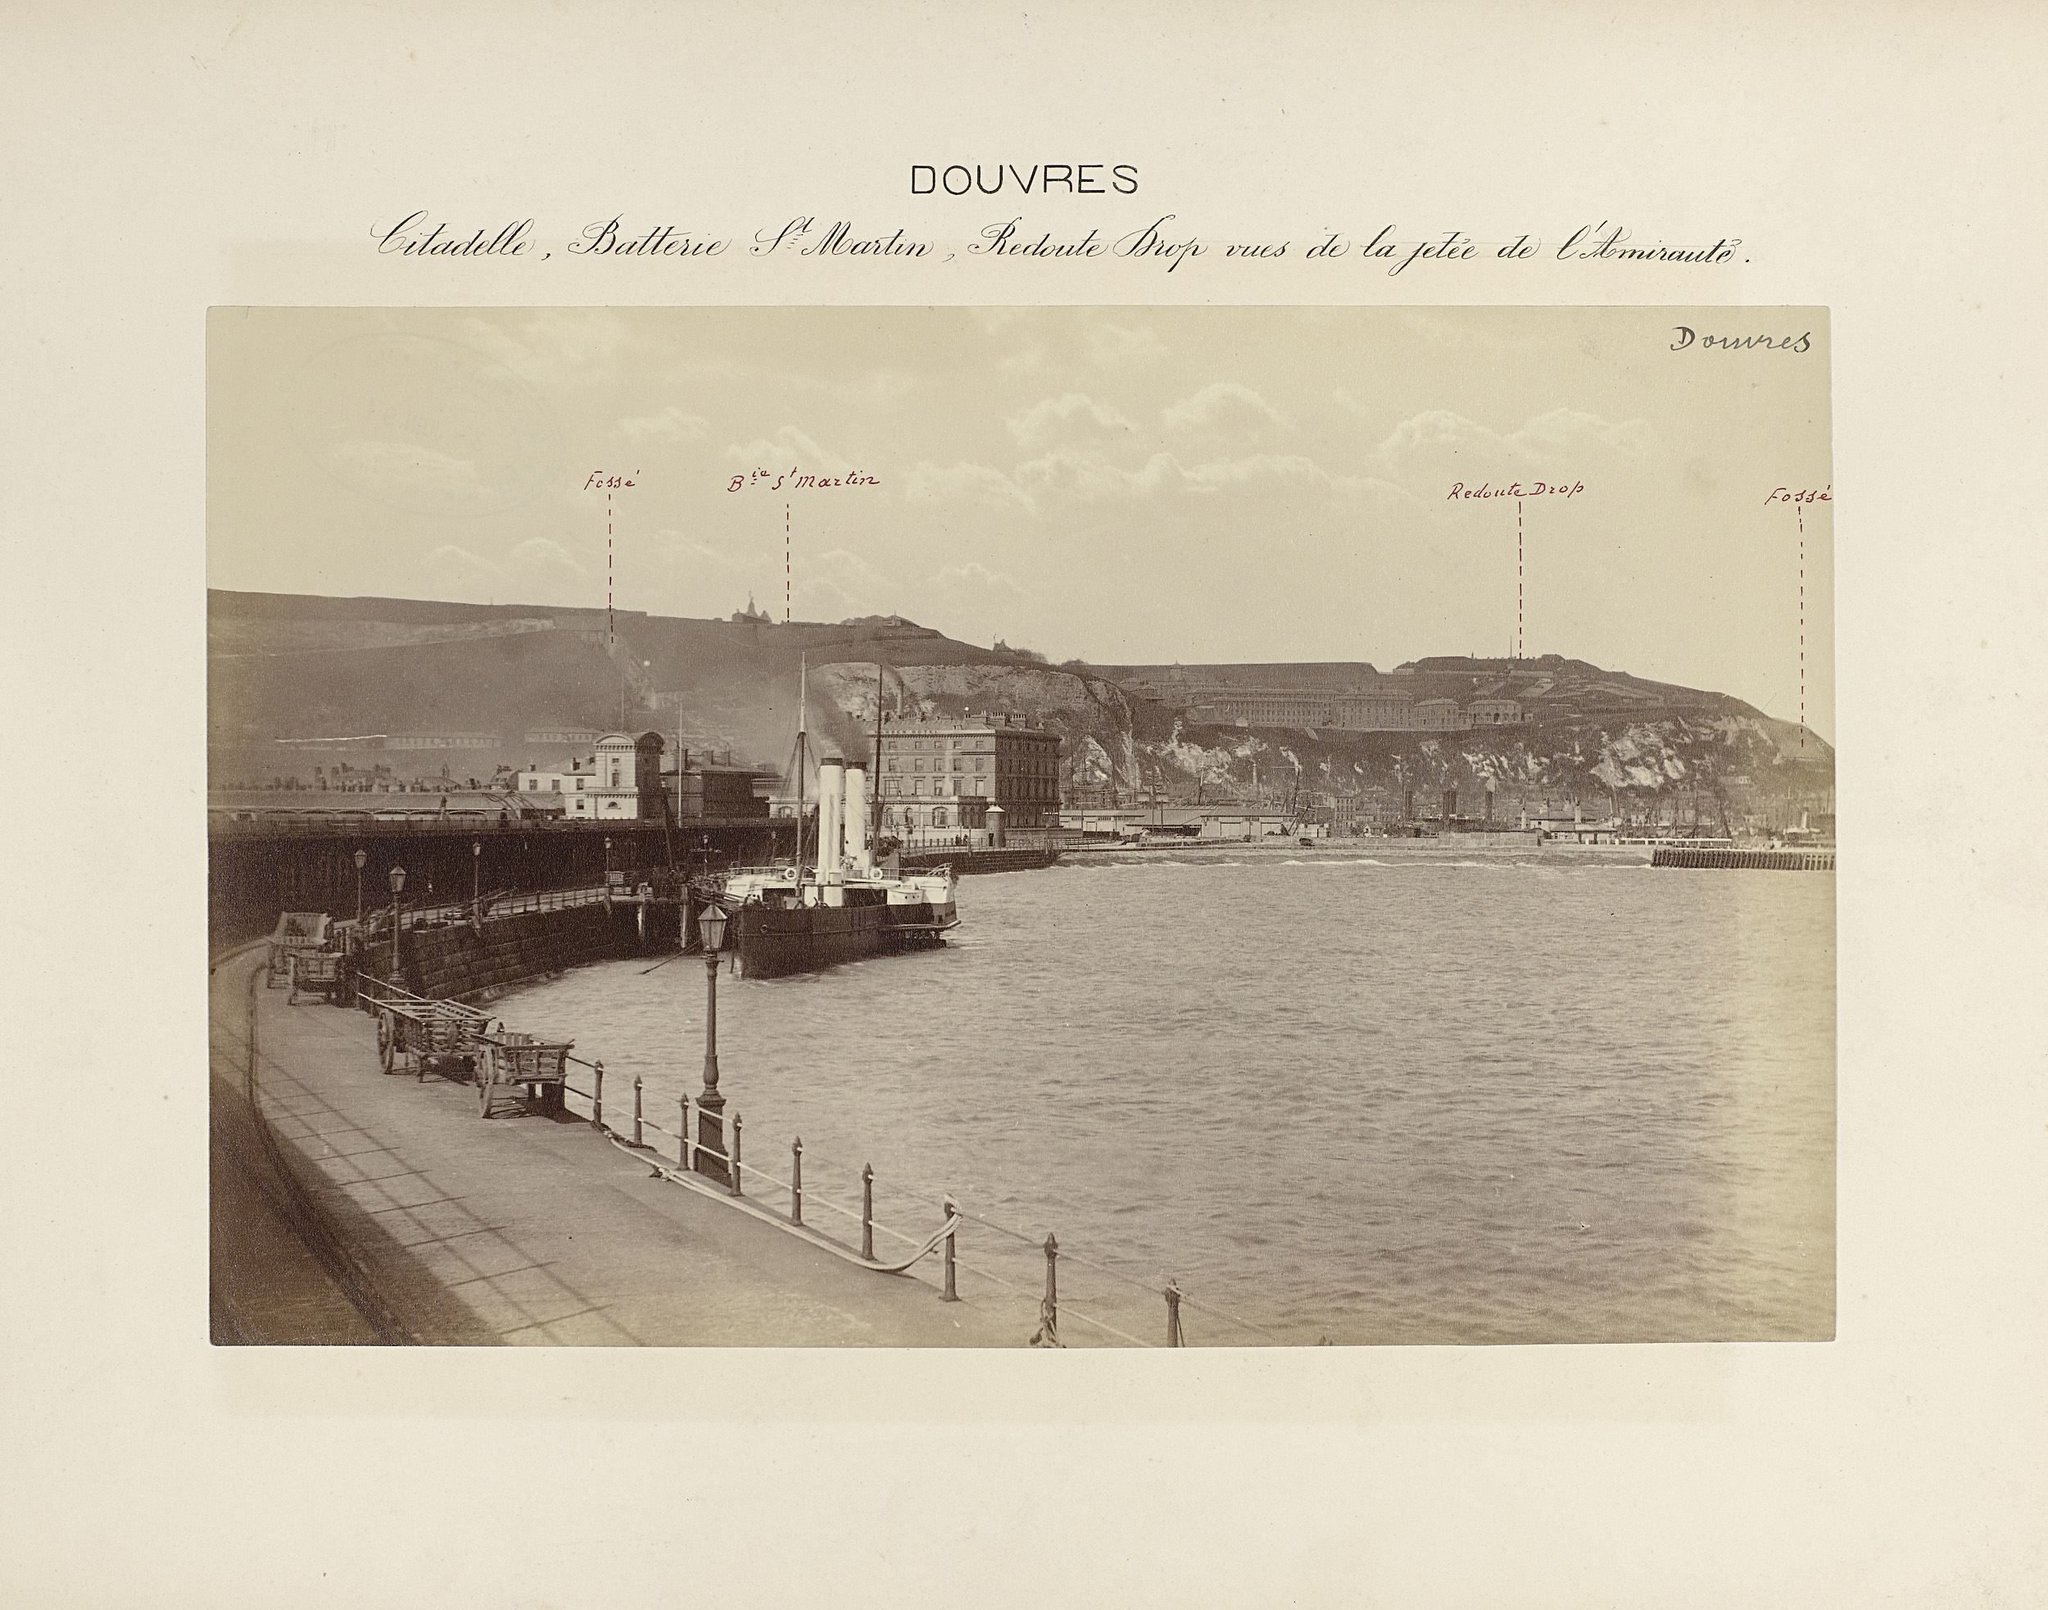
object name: photograph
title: Angleterre. Défense des côtes. Reconaissance de 1891. Photographies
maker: Anonymous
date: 1891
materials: cardboard, paper, photographic support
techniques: albumen print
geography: great britain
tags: dover (engeland)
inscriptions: annotation: ‘Fossé // B[atter]ie St Martin // Redoute Drop // Fossé’, inscription: ‘Douvres’, inscription: ‘DOUVRES / Citadelle, Batterie St Martin, Redoute Drop vues de la jetée de l'Admirauté’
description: Foto uit een album met 35 topografische foto's van Britse kustplaatsen, waarop in pen militaire verdedigingswerken zijn aangegeven door een Franse militair.